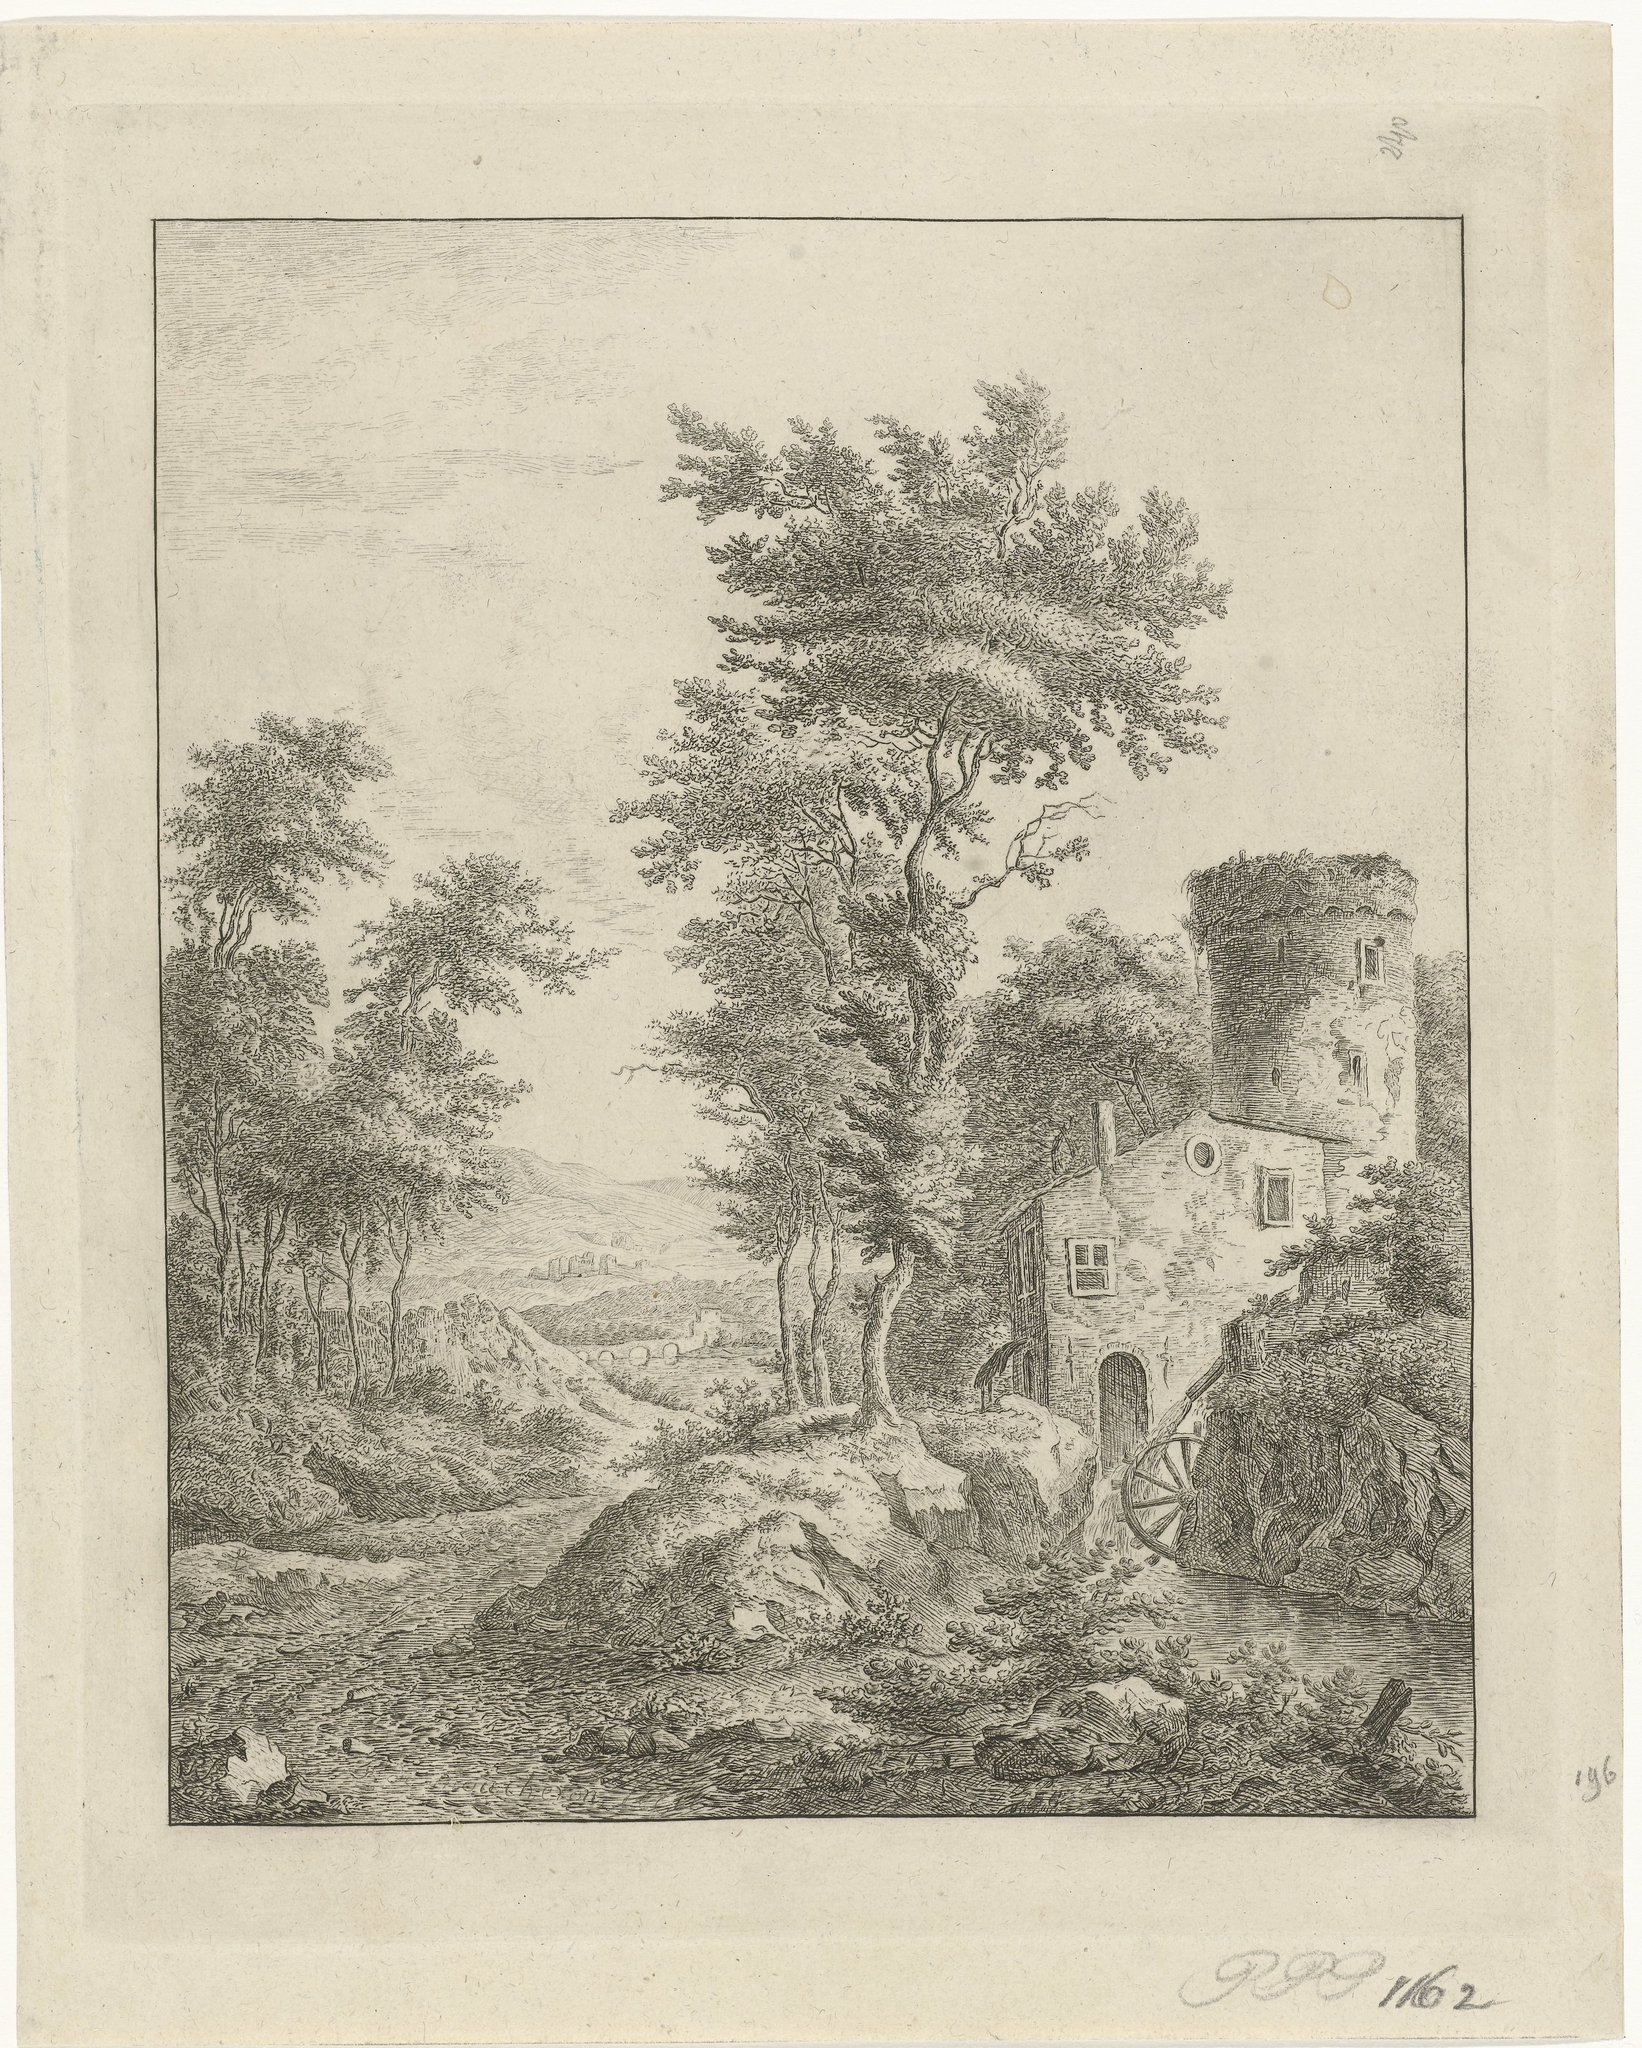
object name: print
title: Landschap met rivier en waterrad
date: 1796-1856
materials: paper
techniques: engraving, etching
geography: vaassen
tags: river, farm or solitary house in landscape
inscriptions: collector's mark: Lugt 2228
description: Een naar beneden stromende rivier met bomen aan weerszijden. Links een huis met een toren en waterrad. Op de achtergrond een dal met een brug of aquaduct.